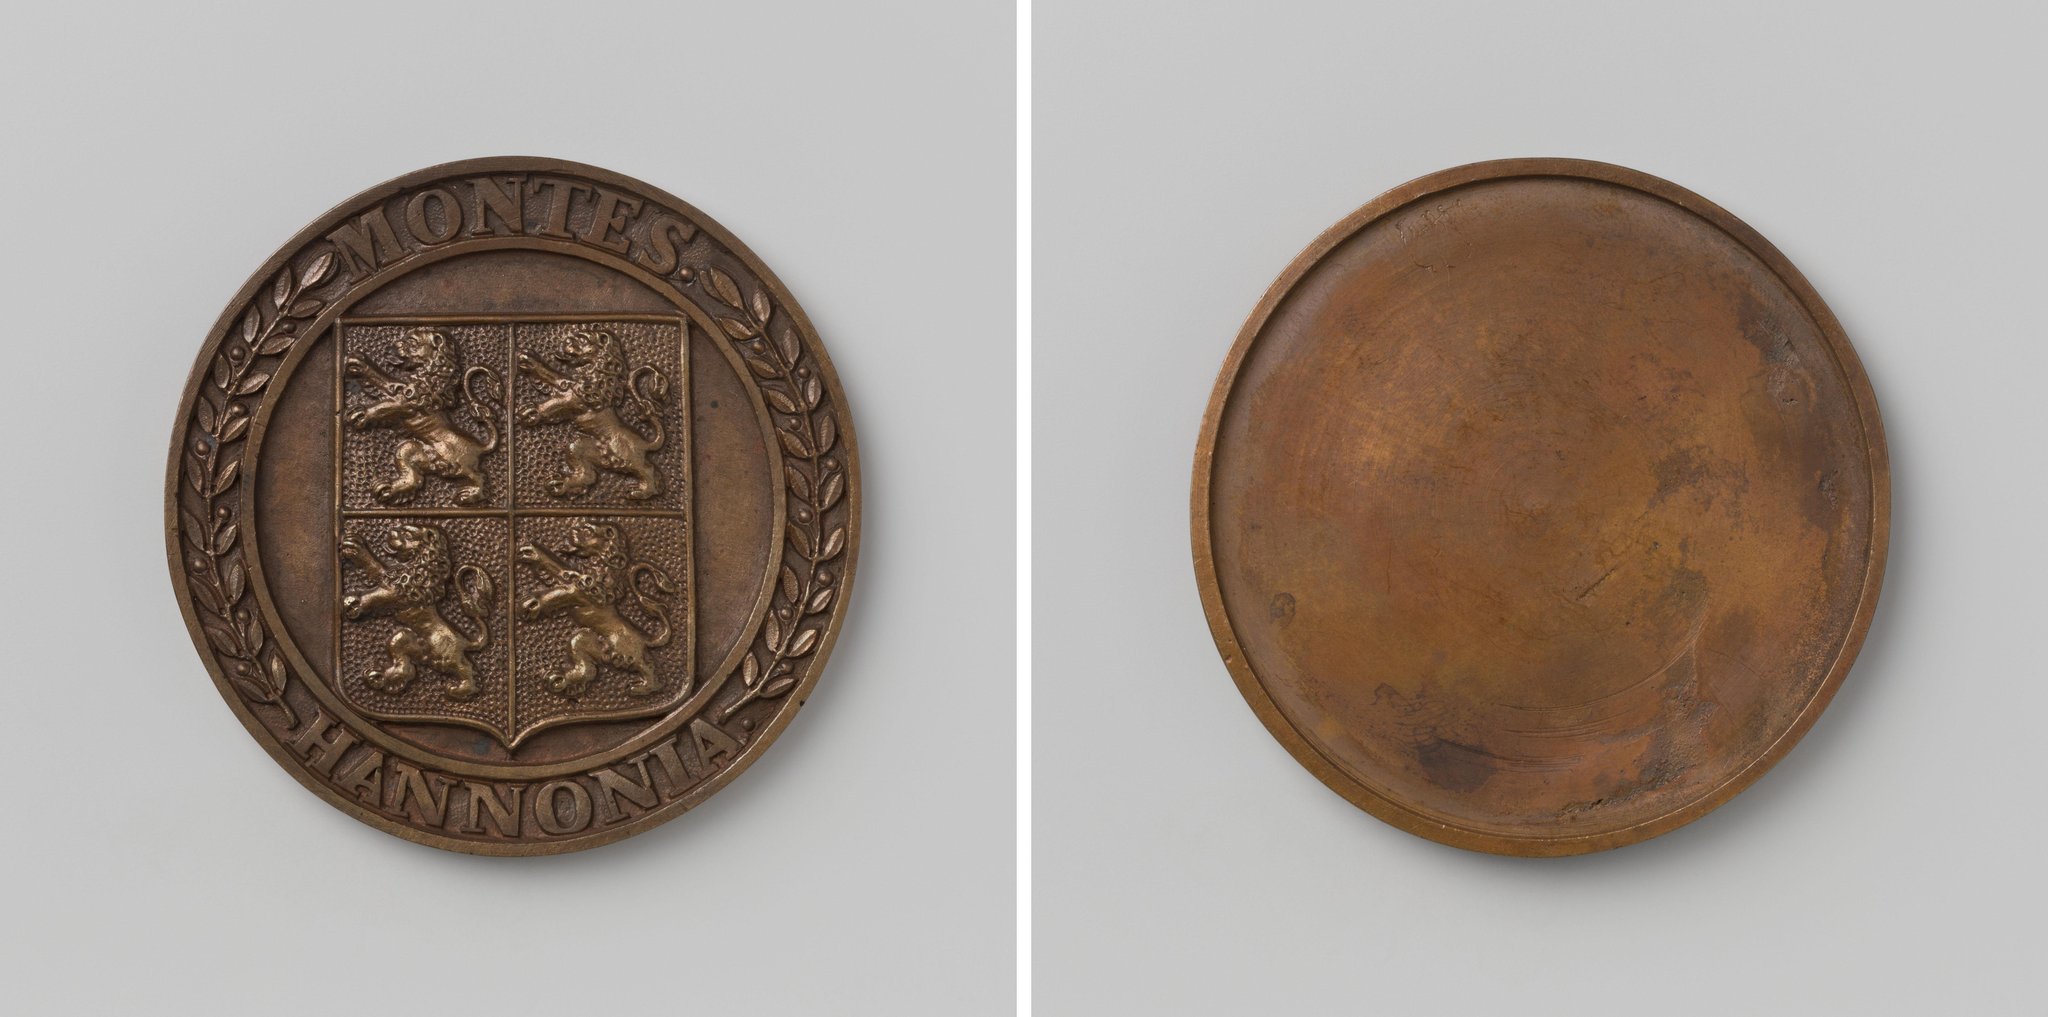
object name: medal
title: Bergen, provincie Henegouwen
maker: Anonymous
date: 1815-1830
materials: bronze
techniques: striking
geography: netherlands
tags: bergen (belgië)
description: Eenzijdige bronzen penning. Voorzijde: wapenschild binnen omschrift, onderbroken door twee takken. Keerzijde: blanco